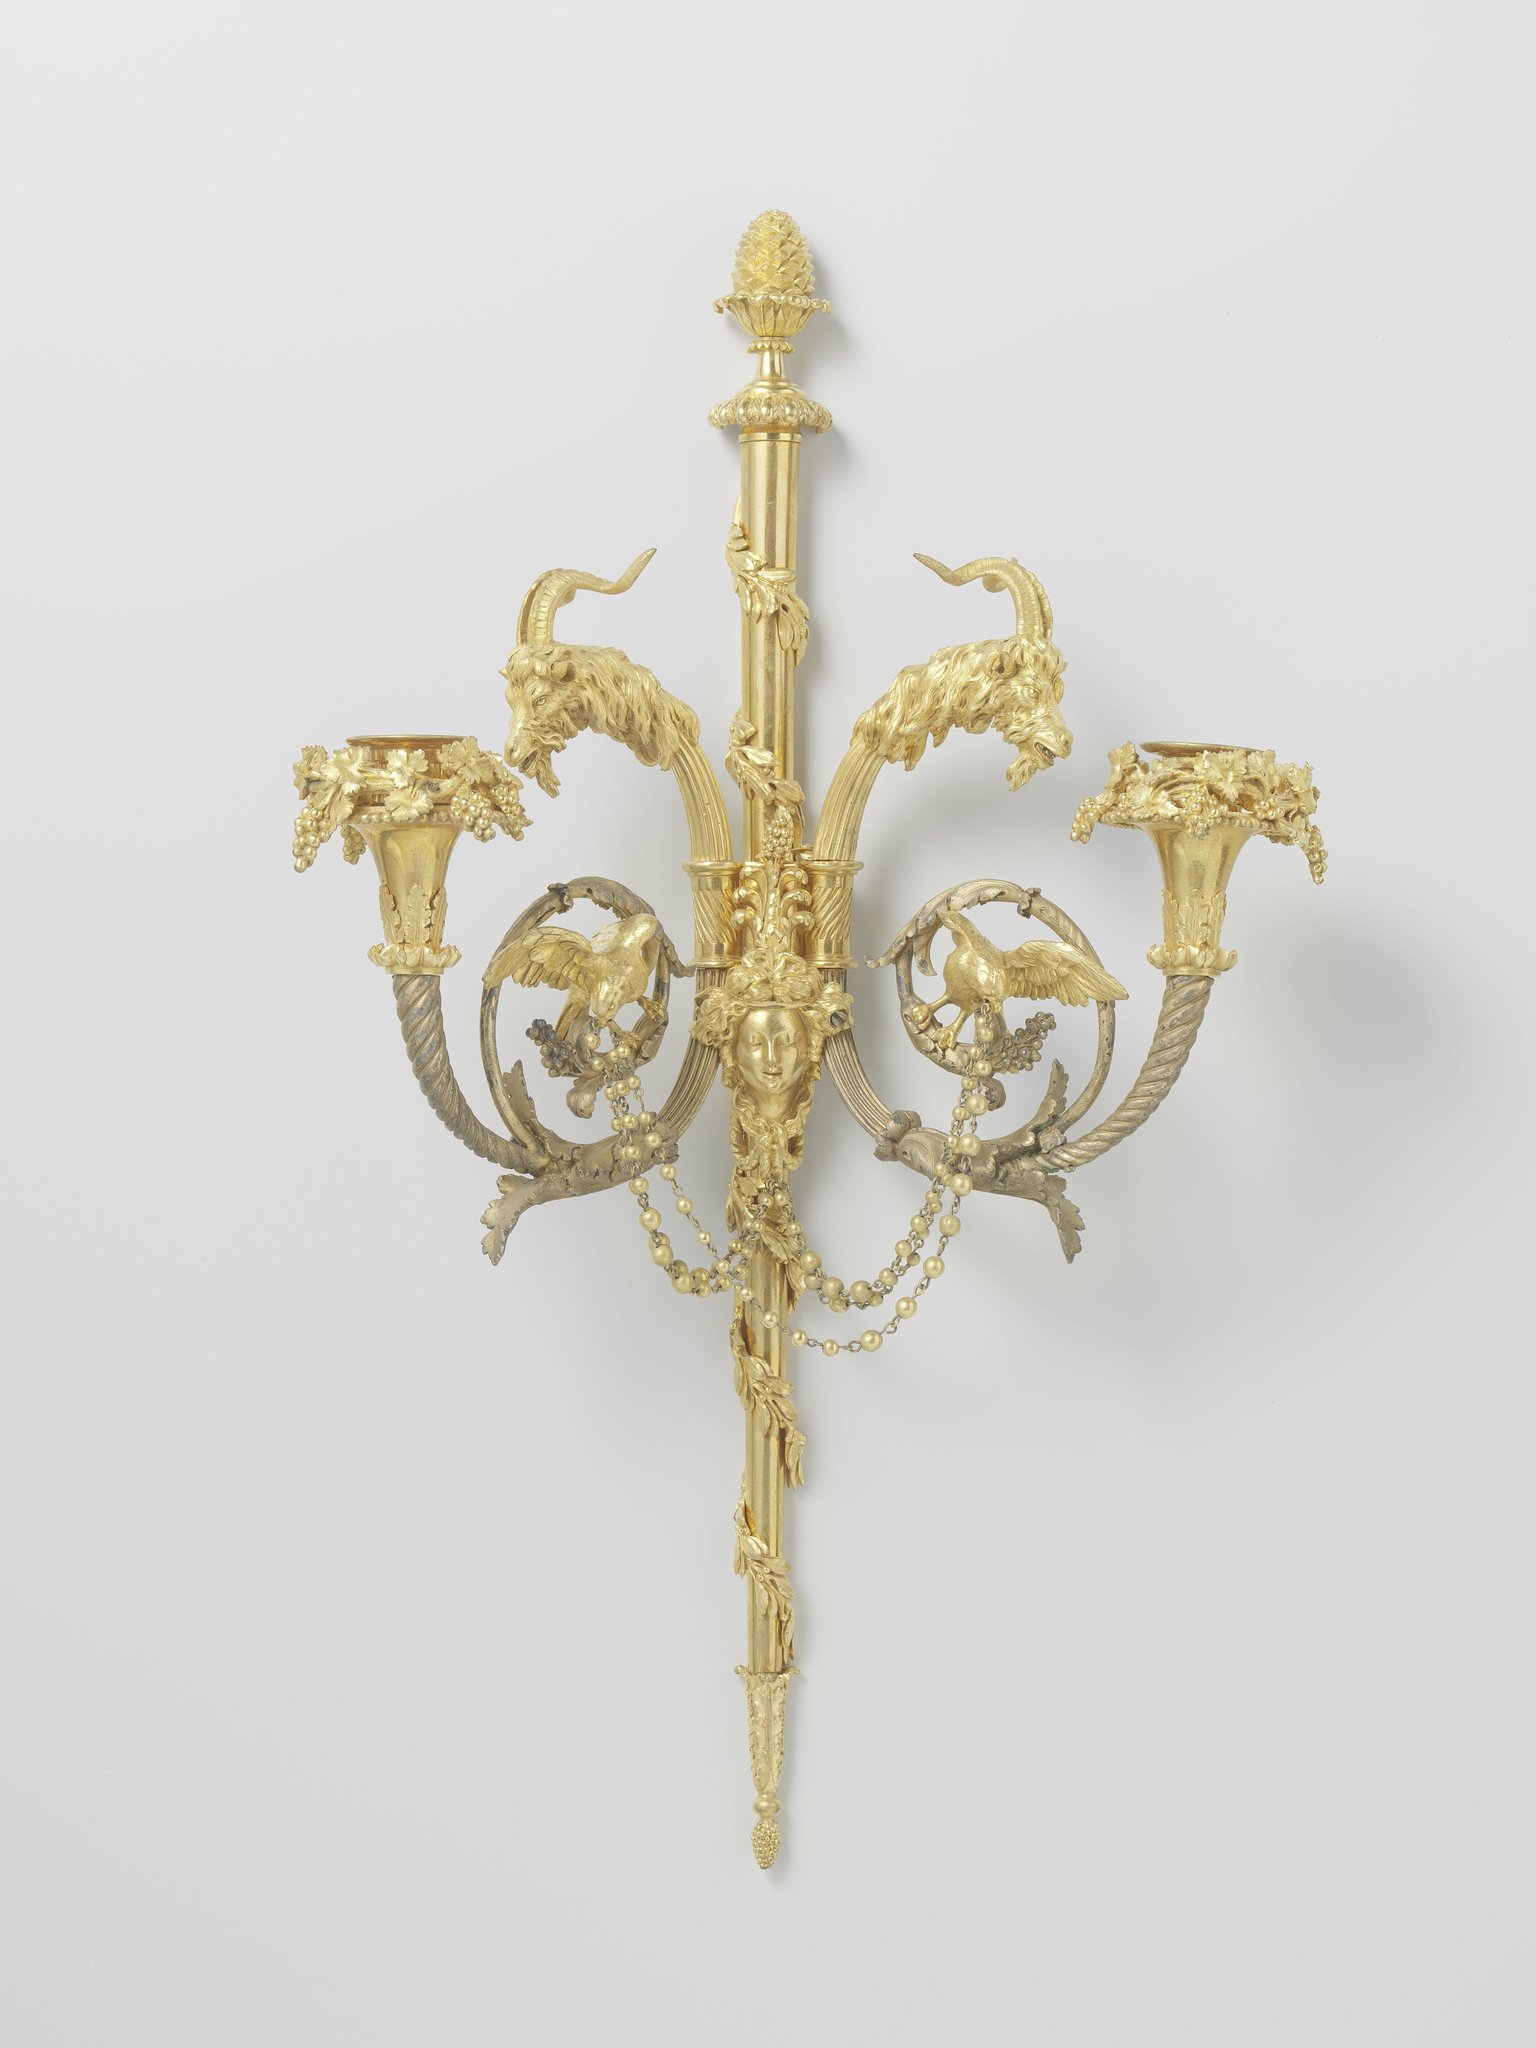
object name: furniture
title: Pair of wall lights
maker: Anonymous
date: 1780-1785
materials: bronze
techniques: gilding, silvering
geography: paris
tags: ram's head ~ ornament, mask, mascaron ~ ornament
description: The airy, elegant style of these wall lights is characteristic of the 1780s. The rams’ heads, the thyrsus (staff wound with laurel branches) and the bunches of grapes refer to Bacchus, the god of wine. Wall lights of this particular model were ordered by various members of the French royal family.